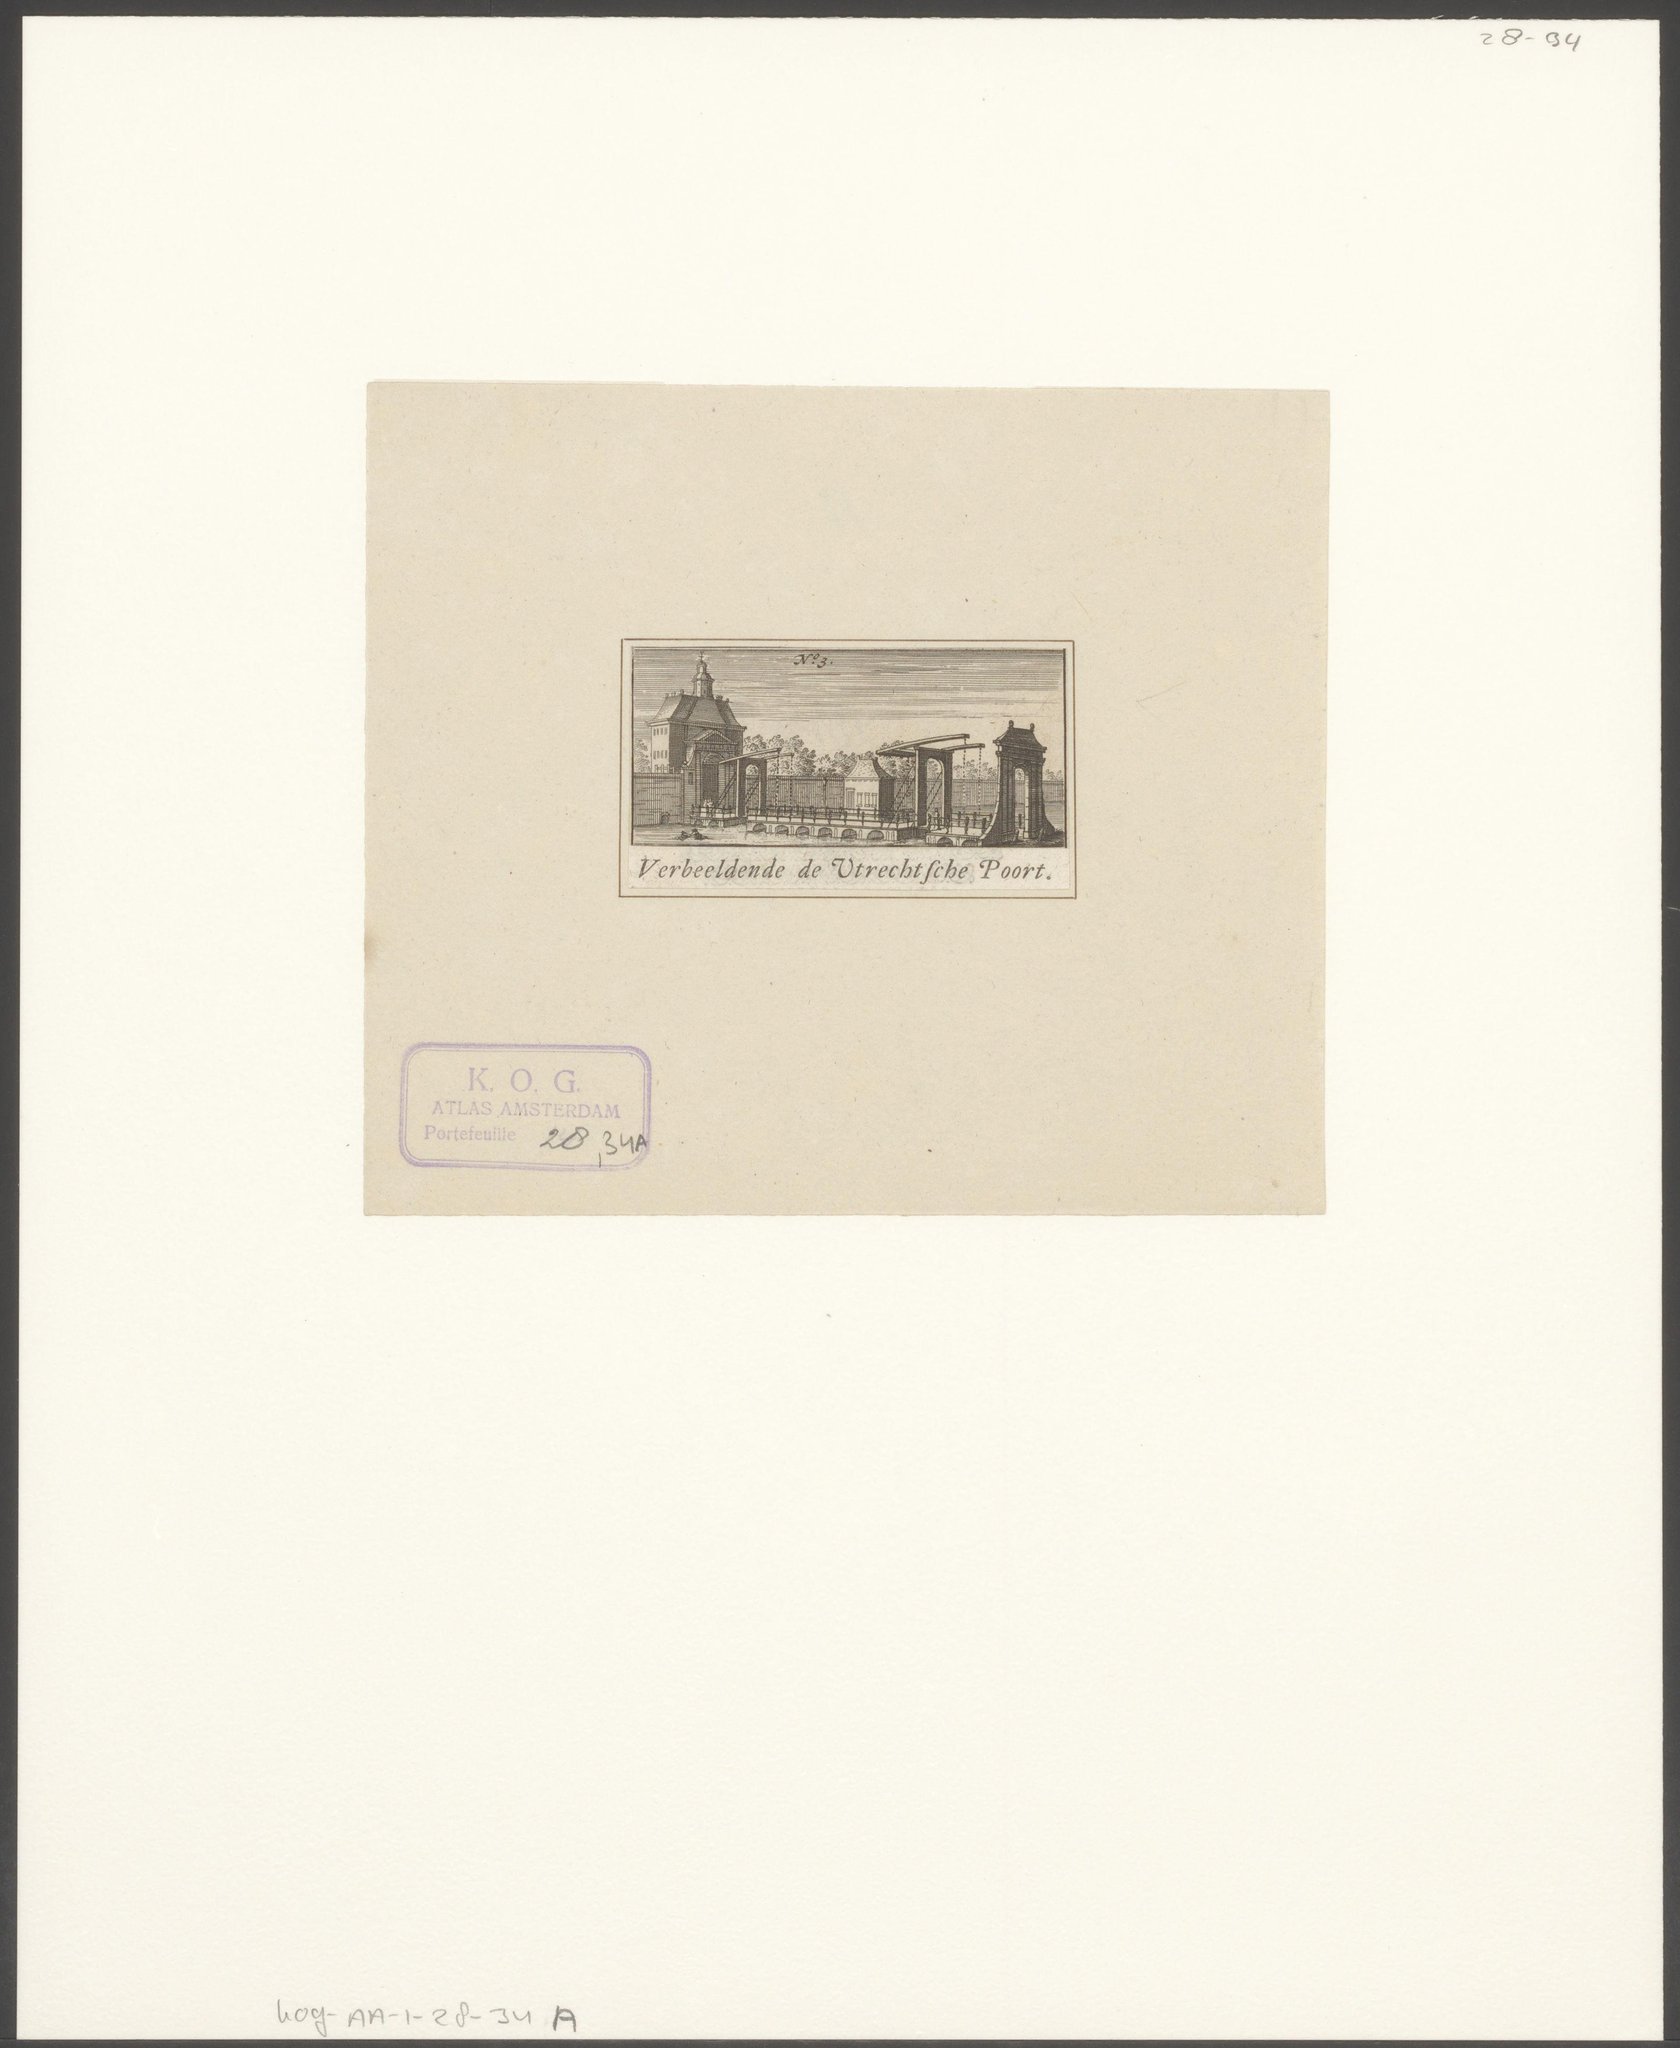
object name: print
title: Verbeeldende de Utrechtsche Poort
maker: jan lamsvelt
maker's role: print maker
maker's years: 1674-1743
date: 1741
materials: paper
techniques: etching, letterpress printing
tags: city-gate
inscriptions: collector's mark: Lugt 1641b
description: Prent waarschijnlijk uit: Gebouwen, gezichten, en oudheden Der Stad Amsterdam. Haarlem: Johannes Marshoorn, 1741. Prent eerder gebruikt in: Leuve, Roeland van. 's Waerelds koopslot of De Amsteldamse beurs. Amsterdam: Jacobus Verheyden (I), 1723.